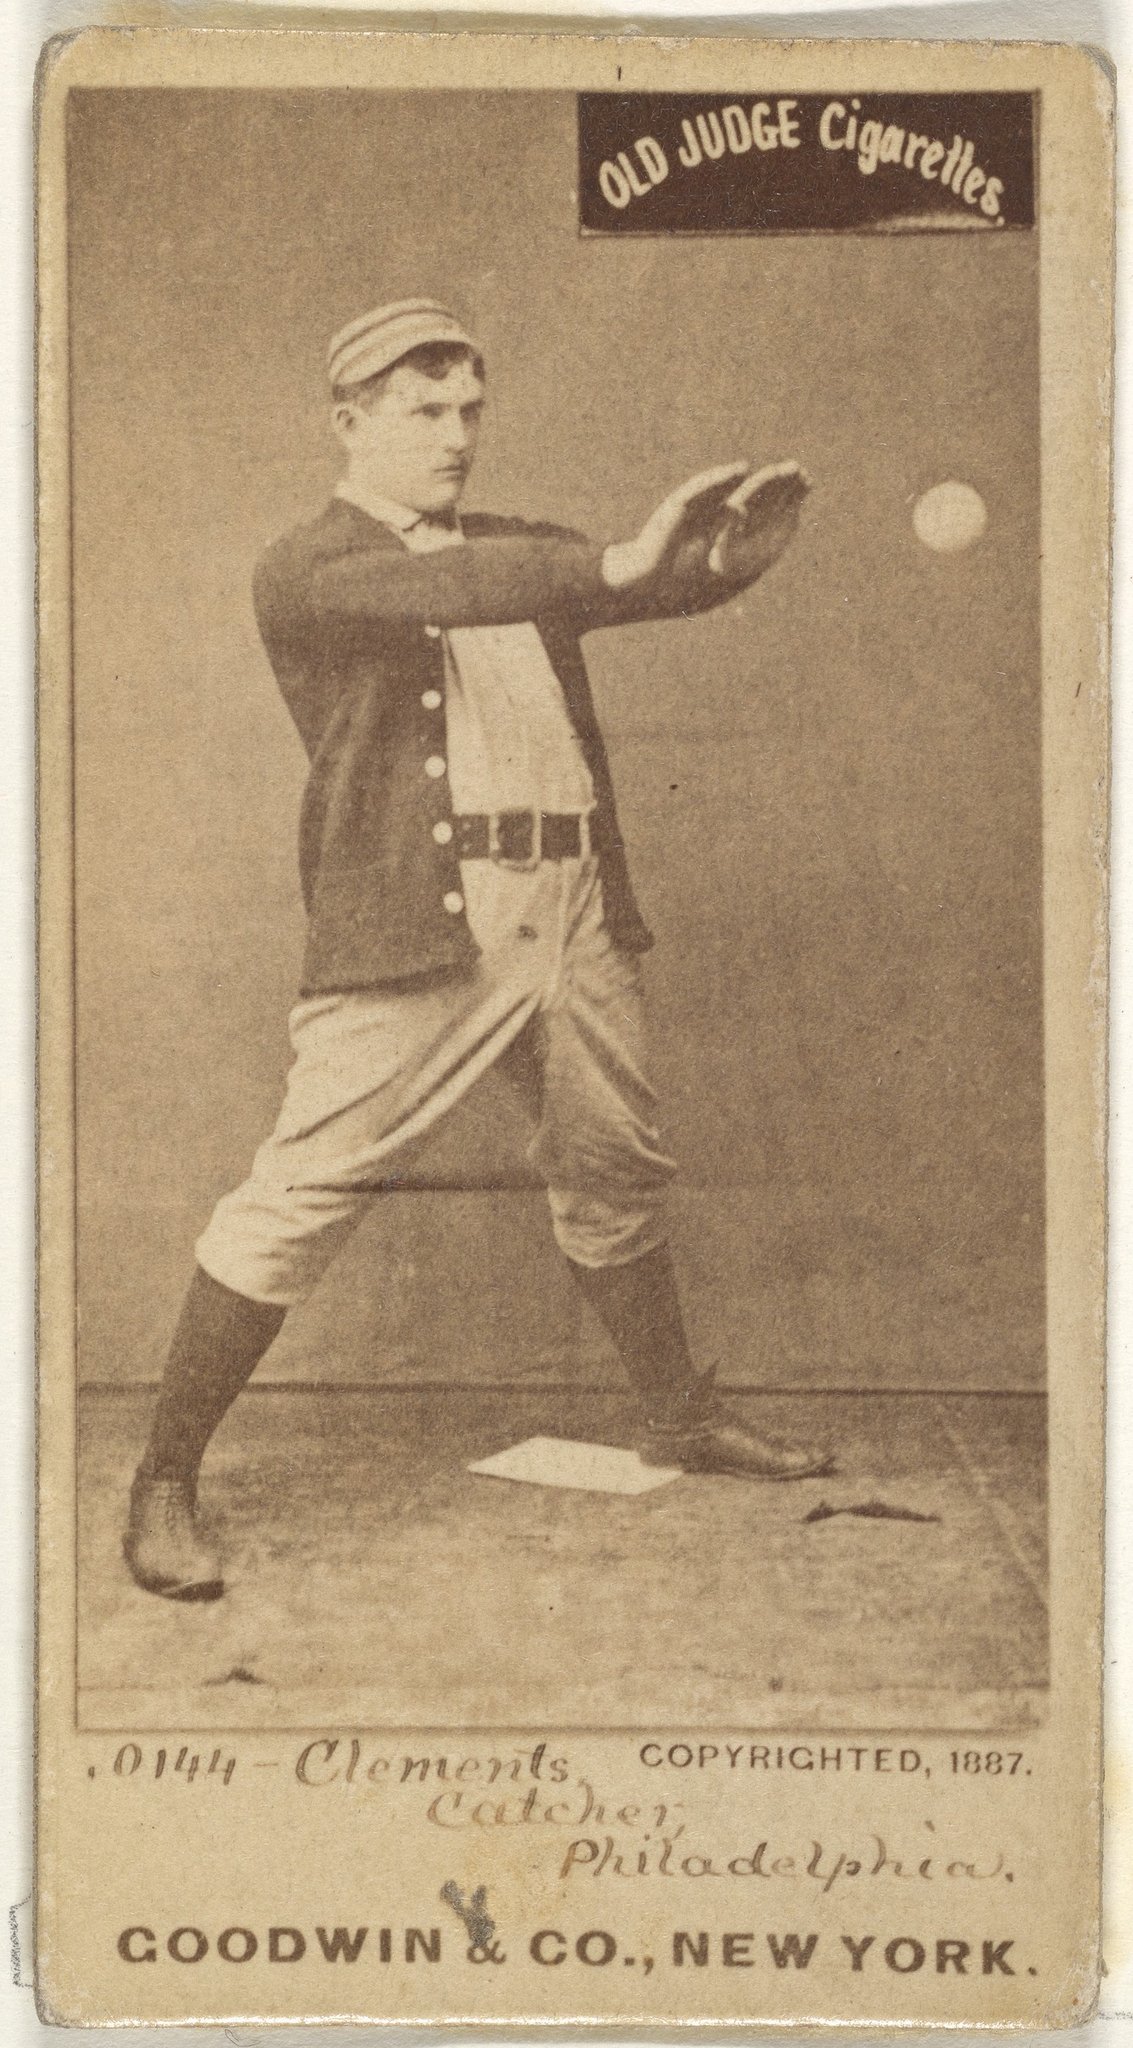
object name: baseball card, photograph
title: John J. "Jack" Clements, Catcher, Philadelphia, from the Old Judge series (N172) for Old Judge Cigarettes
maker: goodwin & company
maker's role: publisher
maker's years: 1850-1950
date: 1887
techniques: albumen silver print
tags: men,portraits,baseball,athletes